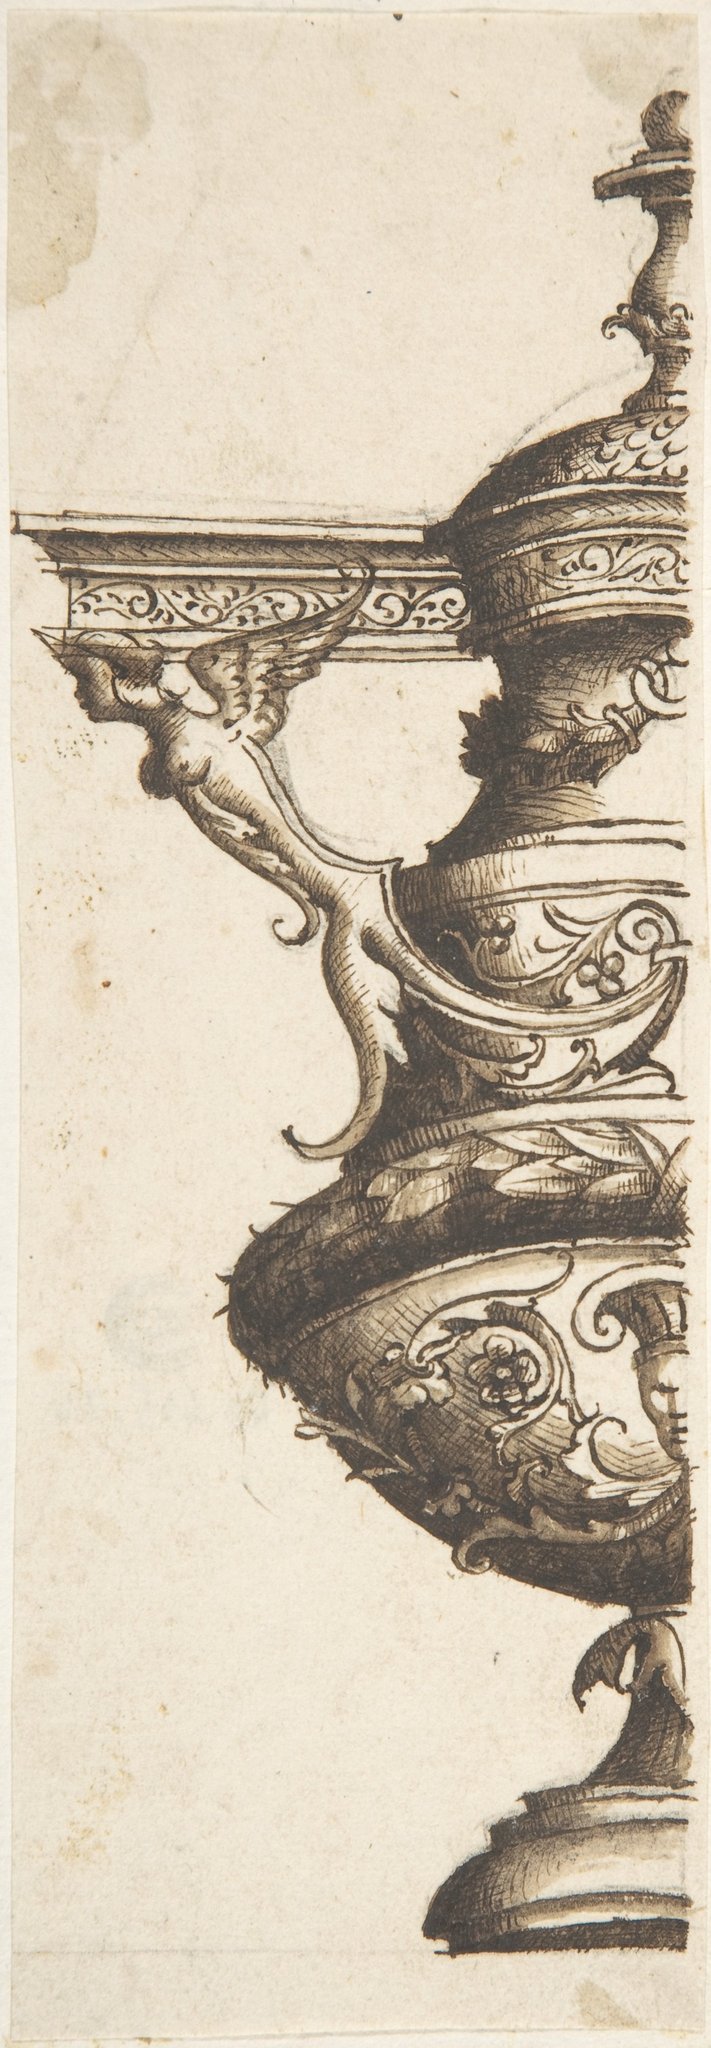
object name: drawing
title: Ornament design after the antique; half-vase with Harpy and Entablature Handle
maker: anonymous, italian, 16th century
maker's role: artist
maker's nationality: italian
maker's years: 1500-1600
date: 1501-1600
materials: charcoal, ink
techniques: brush, pen, wash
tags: ornament,vases